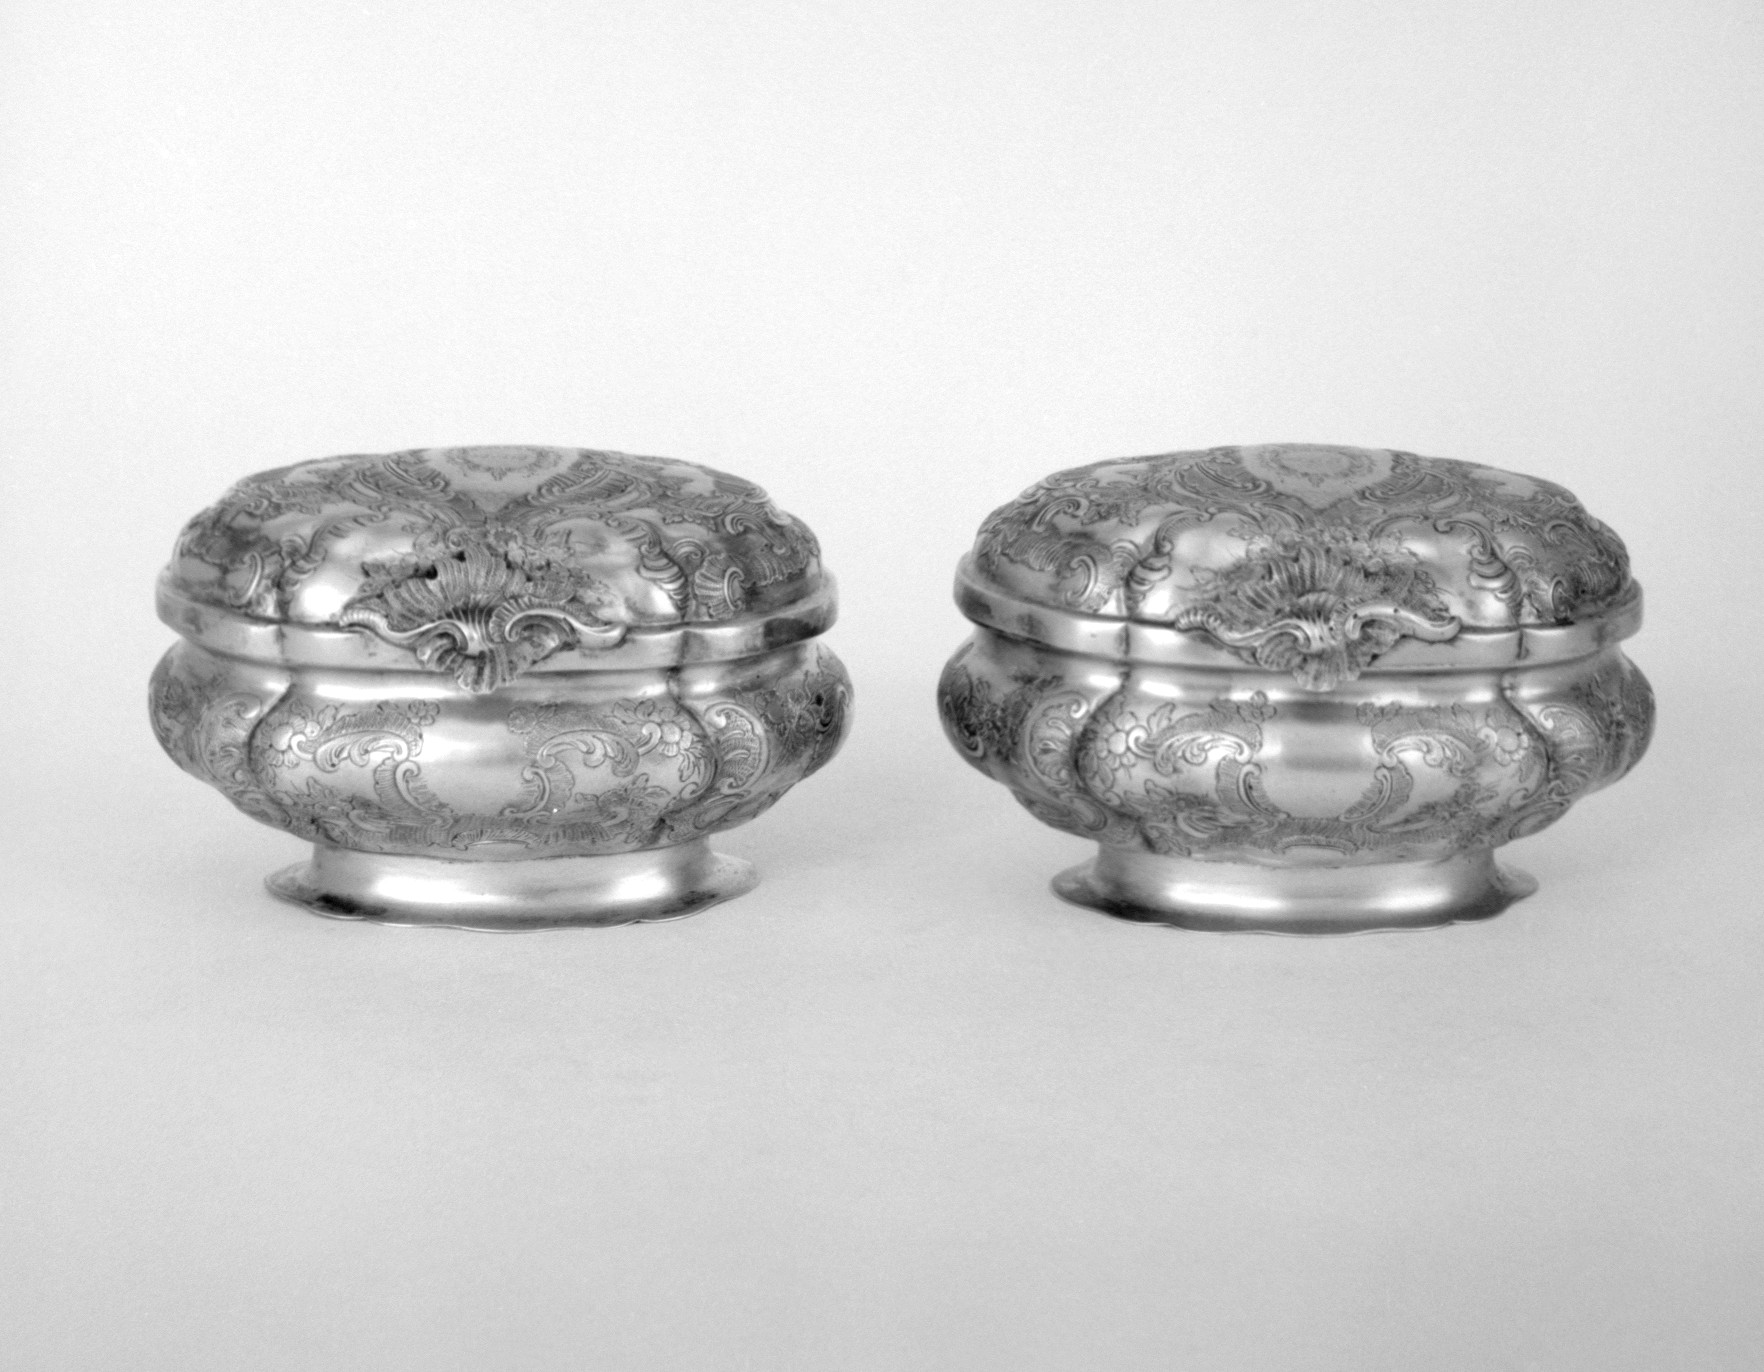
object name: box with cover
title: Small oval box with cover (one of a pair)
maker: johann martin satzger i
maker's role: maker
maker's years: 1707-1785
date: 1755-1757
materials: silver gilt